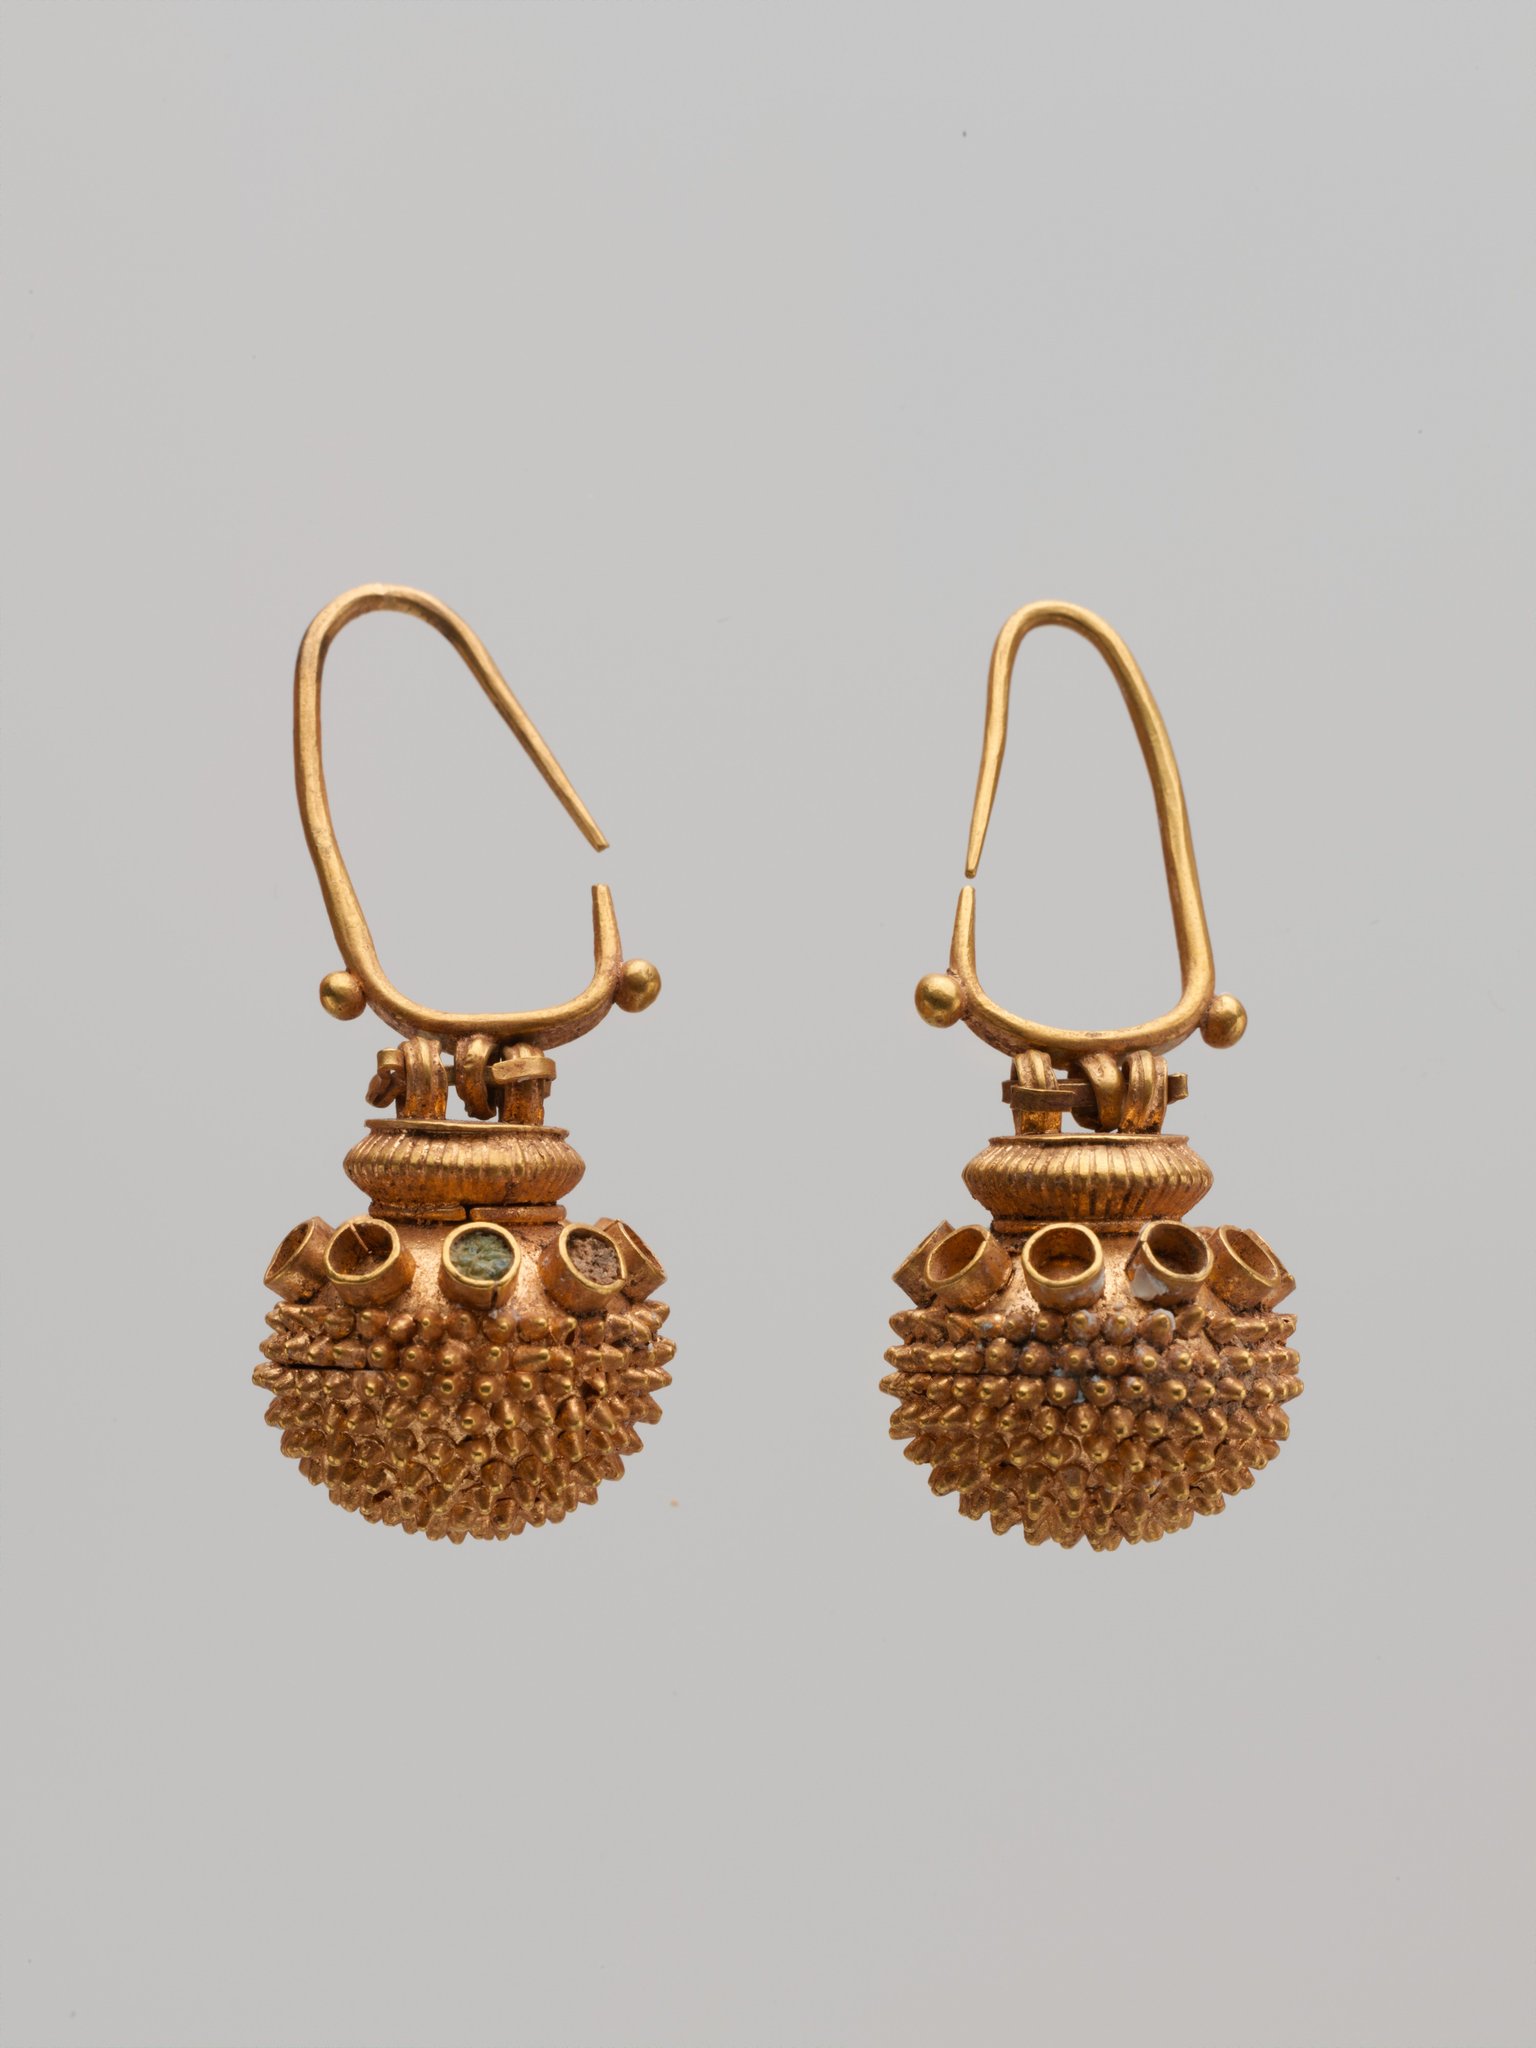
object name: earring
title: Pair of spherical gold earrings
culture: greek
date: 600-401 BCE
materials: enamel, gold